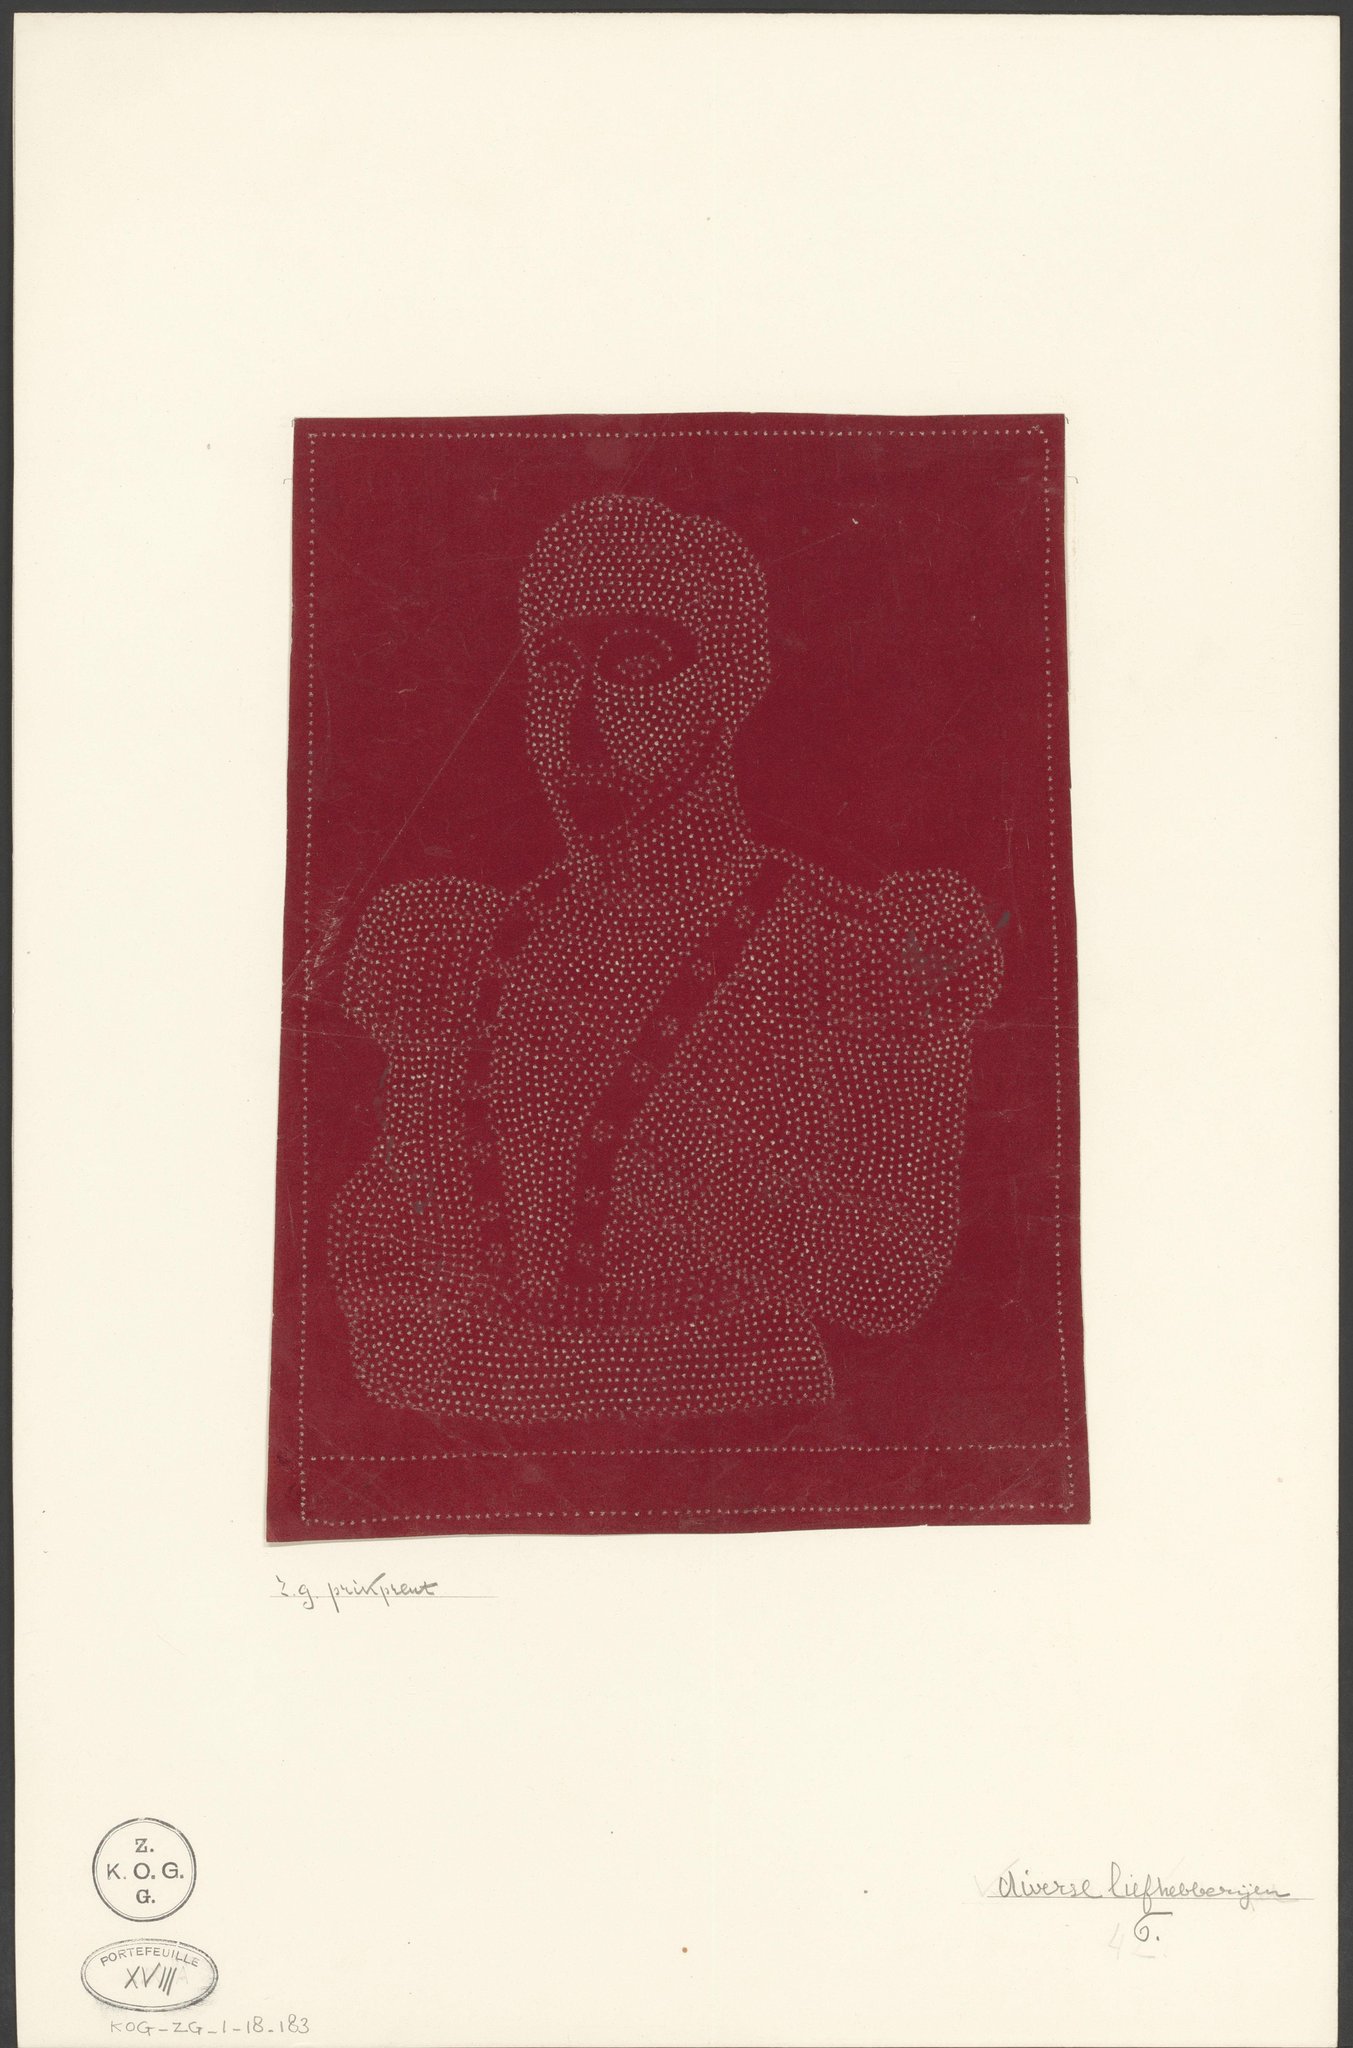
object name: drawing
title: Portret van een onbekende prins of militair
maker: Anonymous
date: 1800-1899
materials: paper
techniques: pricking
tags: helmet, (story of) mars (ares)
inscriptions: stamp, collector's mark: Lugt 1641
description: Onderwerpsrubrieken binnen de Atlas Zeden en Gewoonten: Schoone kunsten, Diverse liefhebberijen (o.a. prikprenten).